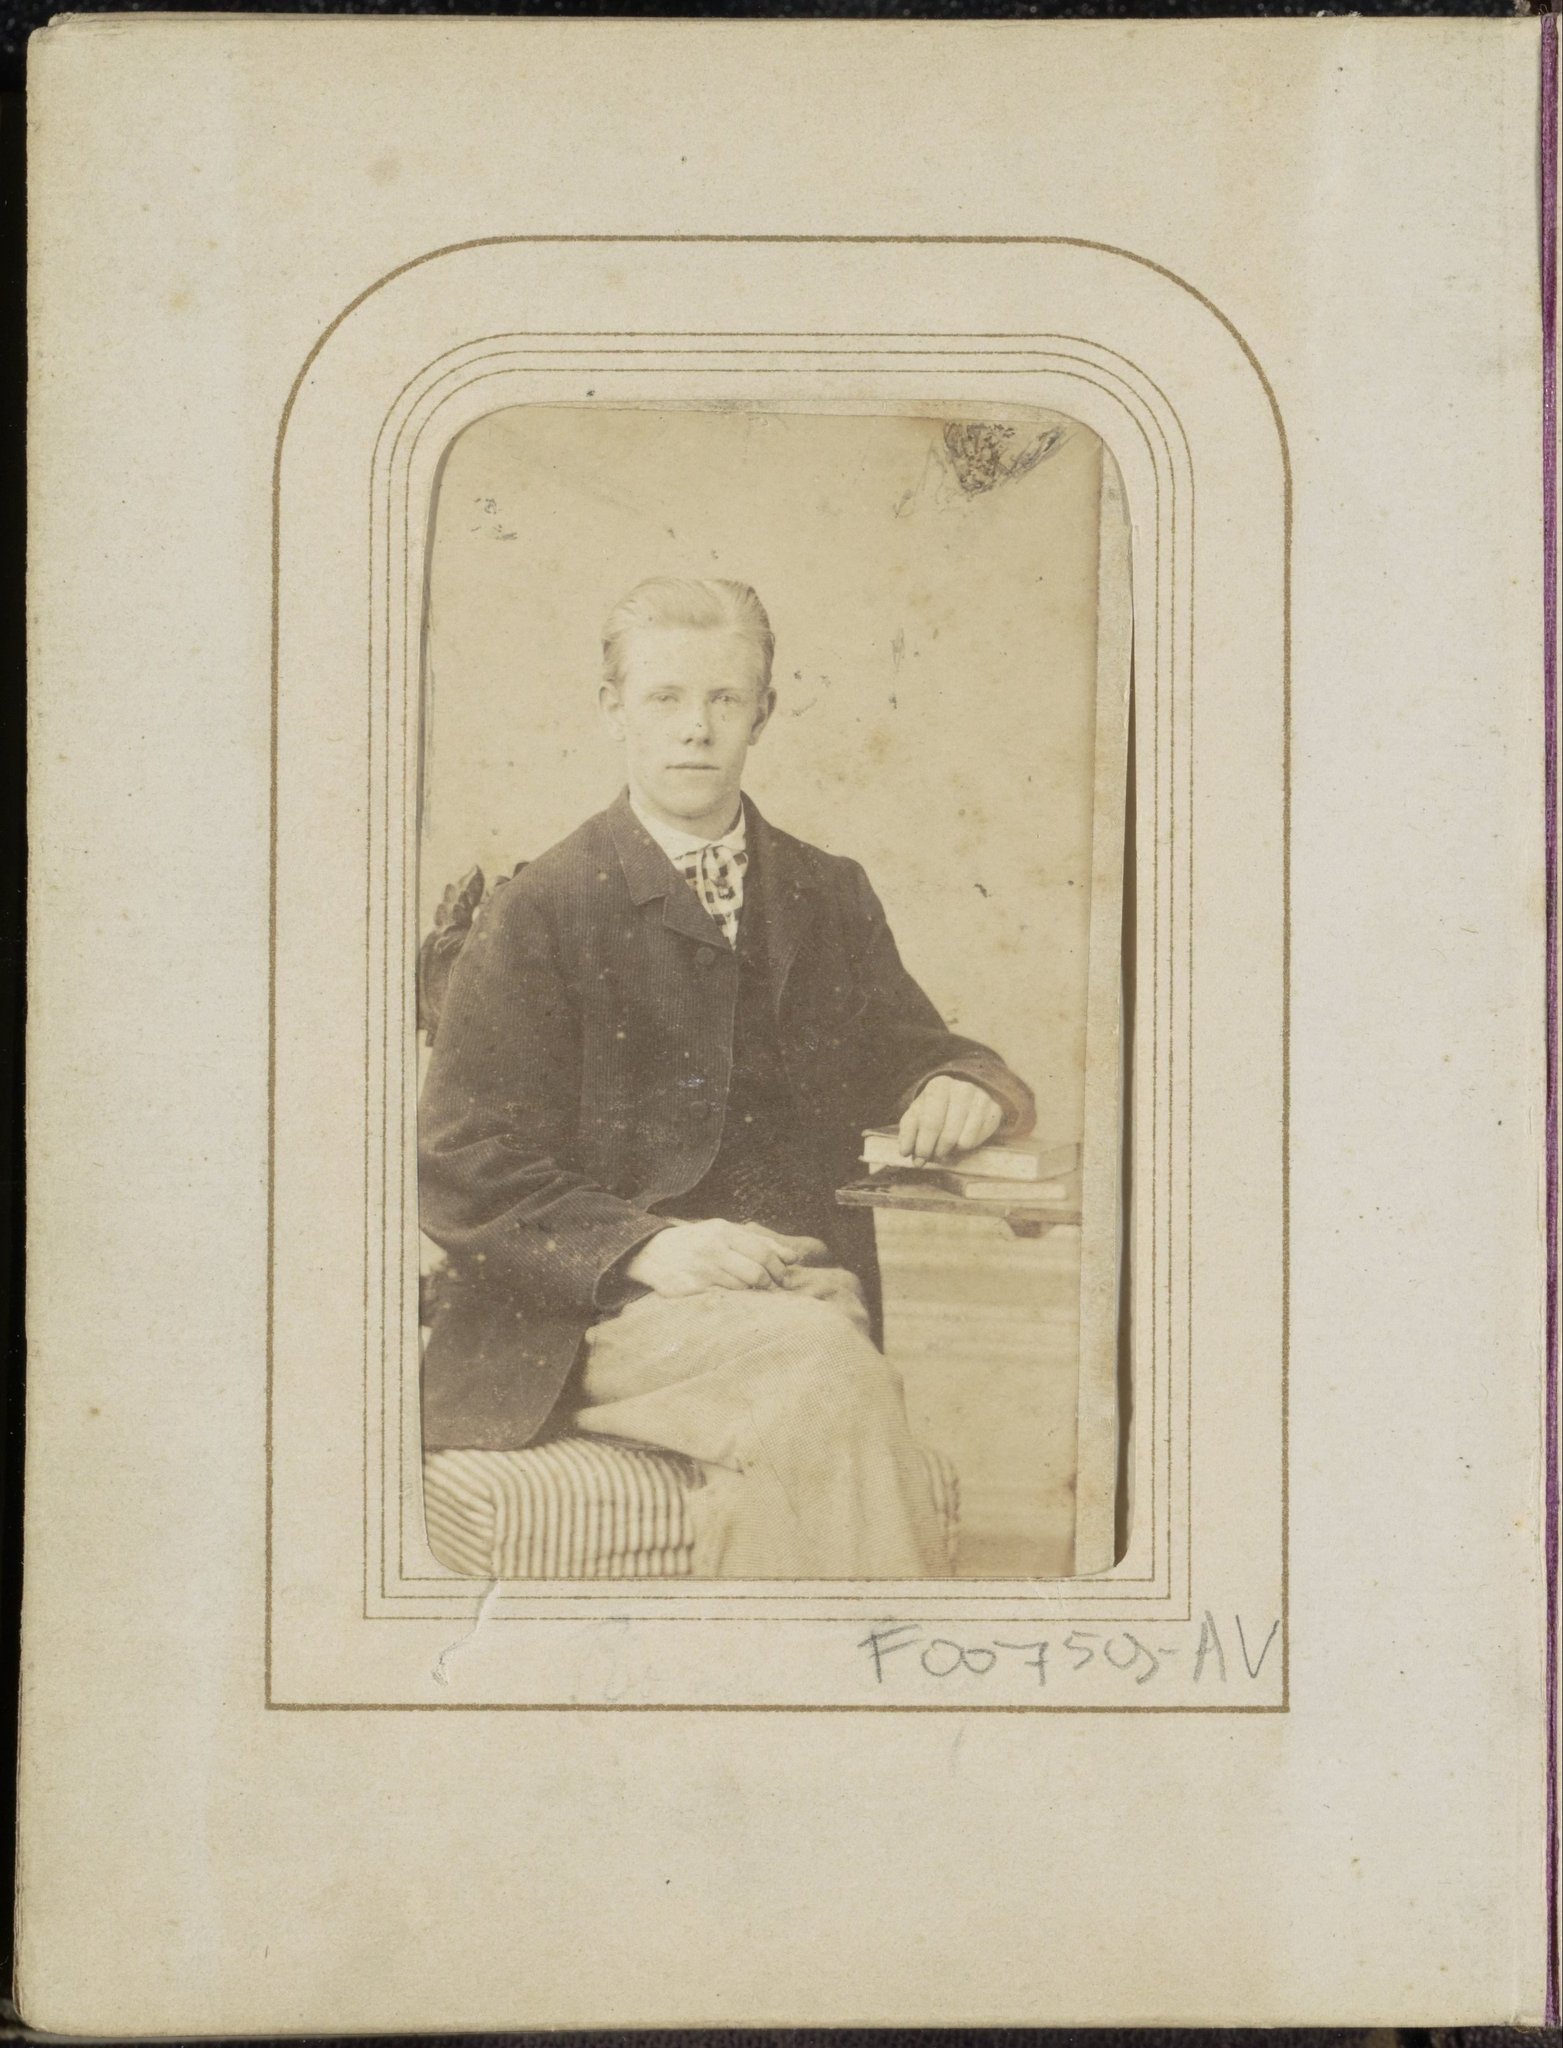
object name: photograph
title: Portret van een jongen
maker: Anonymous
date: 1870-1880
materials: cardboard, paper, photographic support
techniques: albumen print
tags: studio requisites ~ photographer, historical persons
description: Onderdeel van Fotoalbum van een Nederlandse familie met 50 cartes-de-visite.